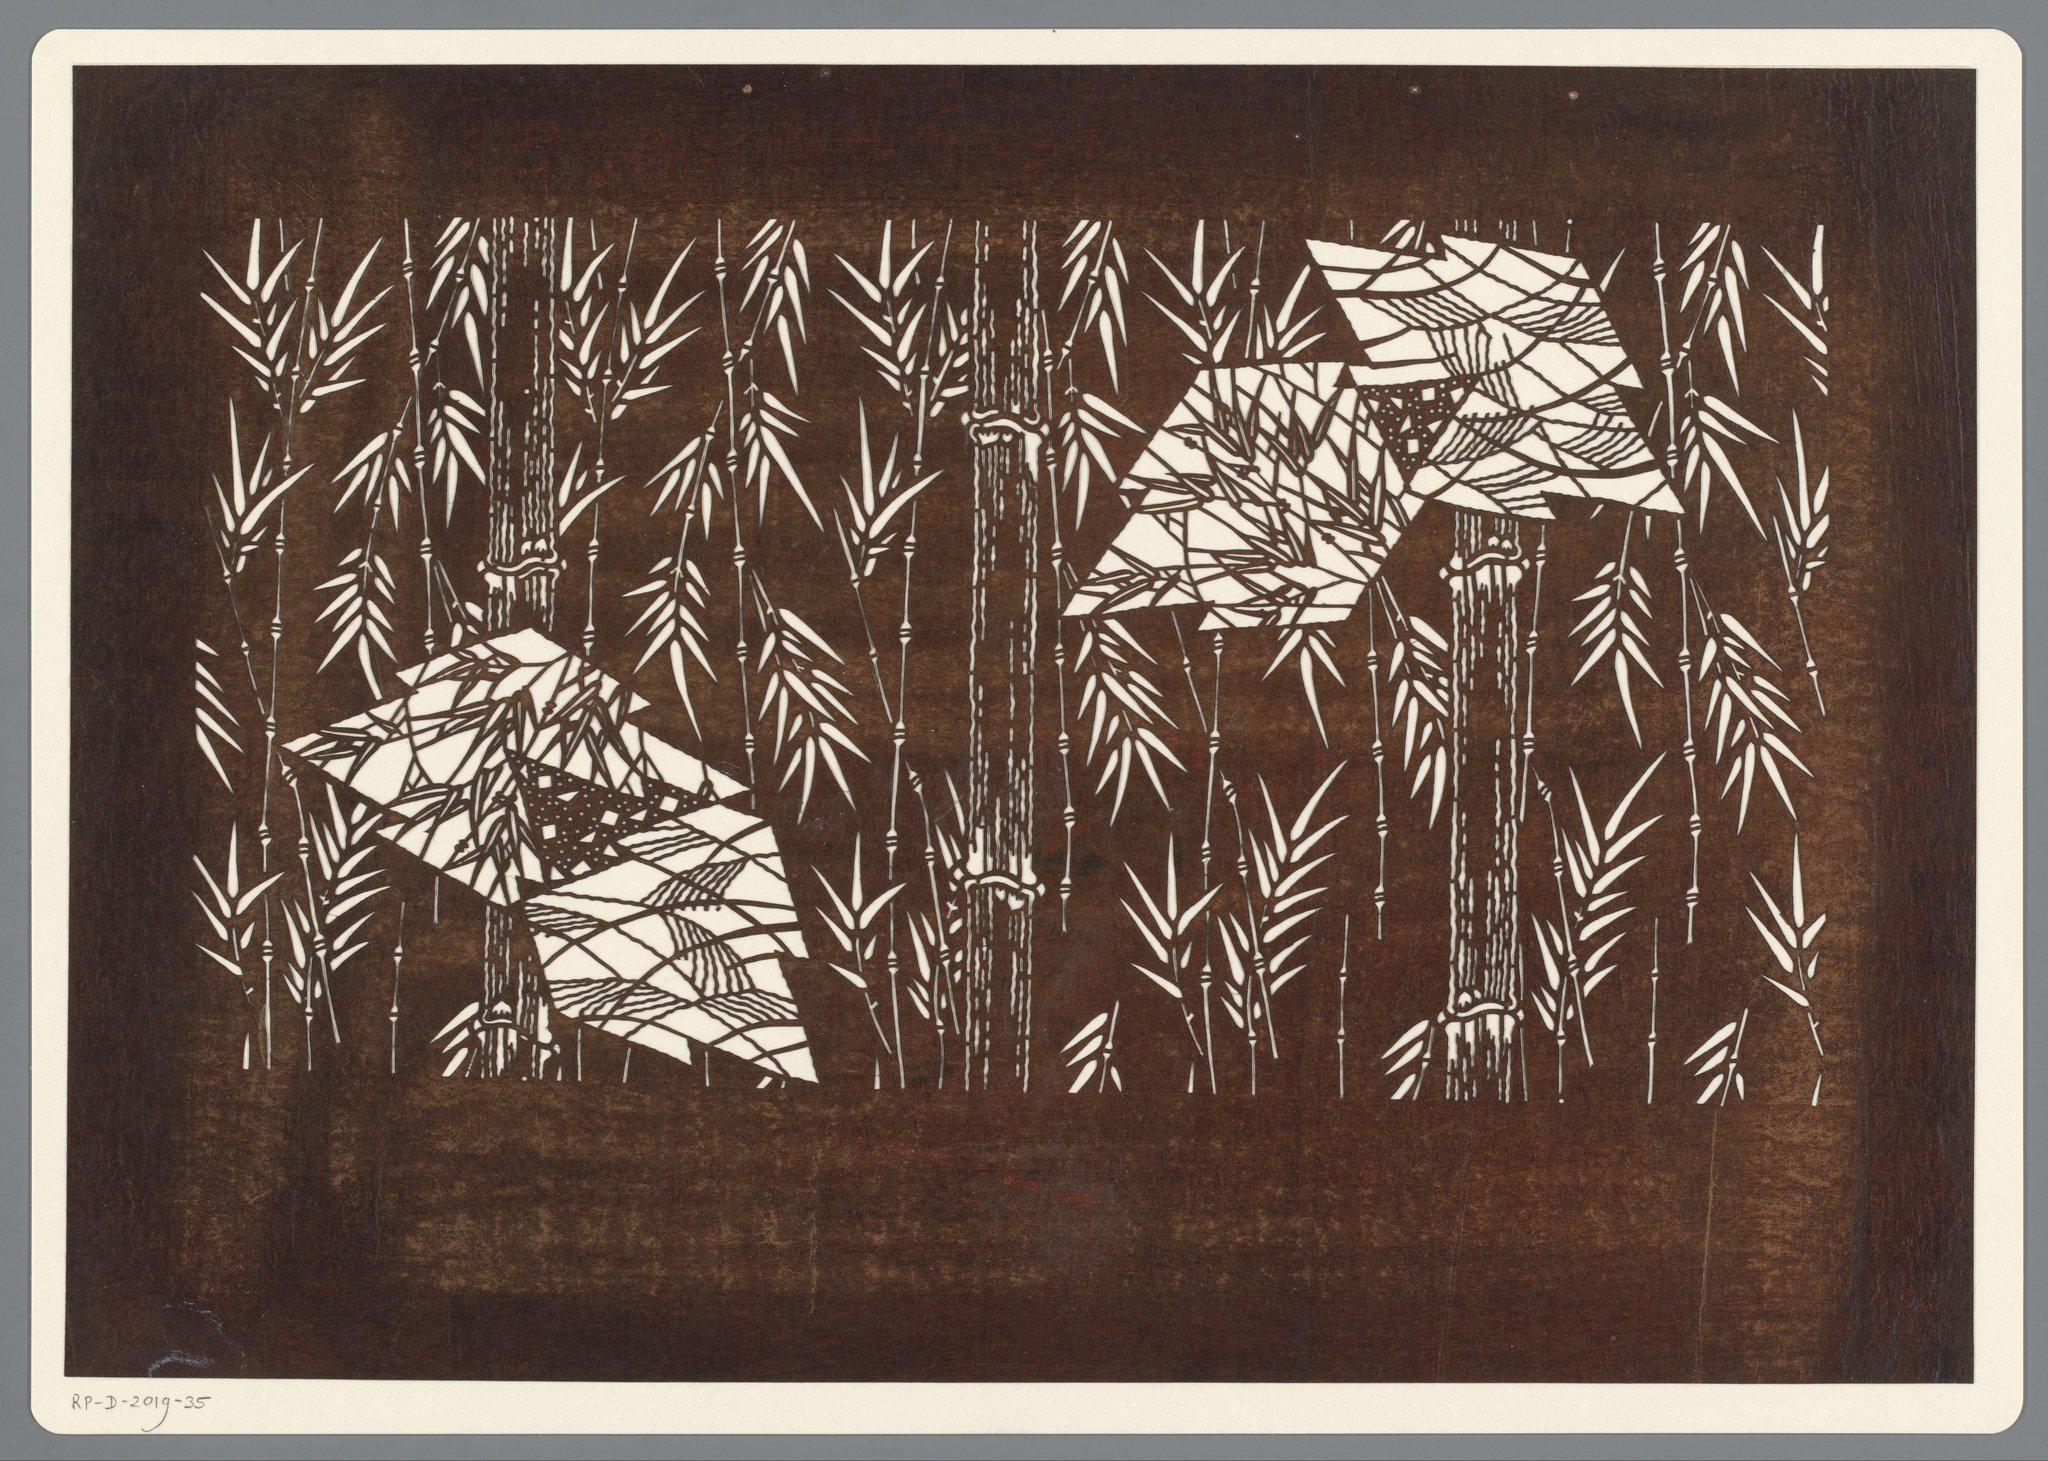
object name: katagami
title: Sjabloon met bamboe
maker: Anonymous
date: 1800-1909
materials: paper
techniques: cutting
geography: japan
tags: plants and herbs: bamboo, foliage, tendrils, branches ~ ornament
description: Japanse sjabloon (katagami) met een patroon van bamboebladeren en stengels, met enkele ruitvormige vormen eroverheen.